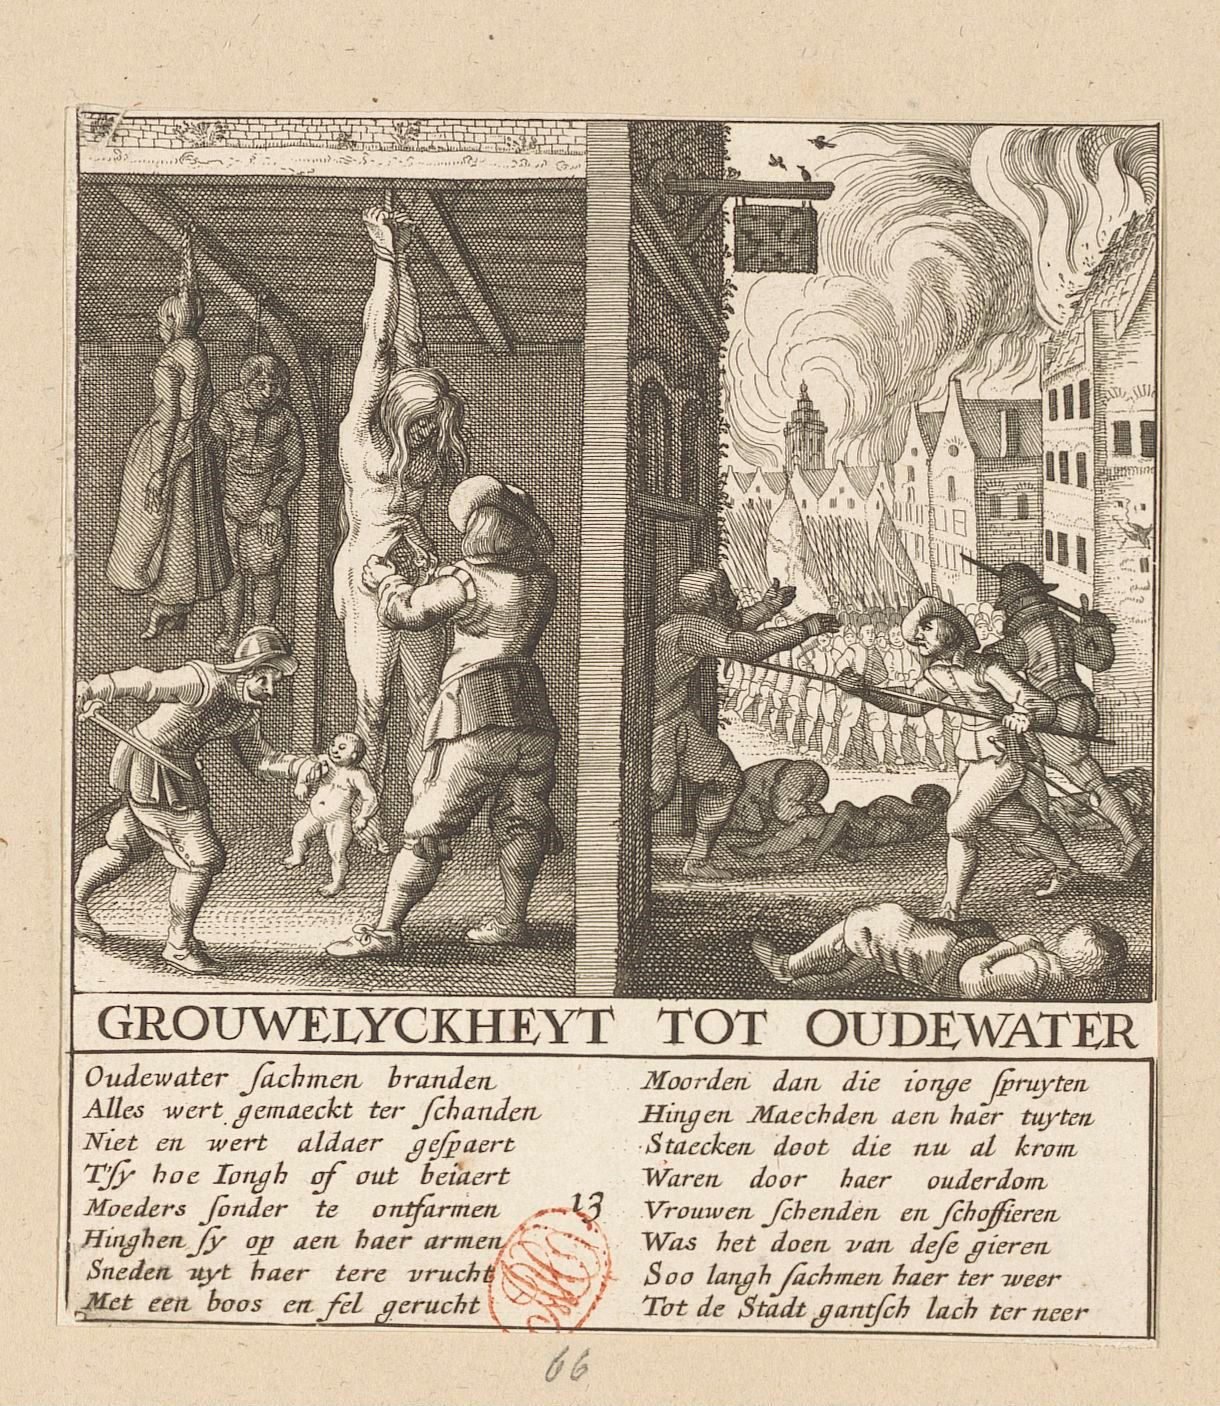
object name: history print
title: Gruwelijkheden te Oudewater, 1575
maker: Anonymous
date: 1618-1624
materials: paper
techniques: etching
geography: netherlands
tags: massacre ~ war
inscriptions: collector's mark: Lugt 195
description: Illustratie voor een (onbekende) uitgave van het populaire en vaak herdrukte werk getiteld: De Spaensche Tiranye gheschiet in Nederlant, waarschijnlijk voor het eerst ca. 1620 verschenen. Zie ook Hollstein (Dutch), vol. XXXVIII (Claes Jansz. Visscher II), p. 165, nr. 425 en een andere versie van dit werk uitgegeven in 1621 te Amsterdam bij C.L. vander Plasse, in de collectie van de Rijksmuseum Research Library, signatuur 327 K 30.